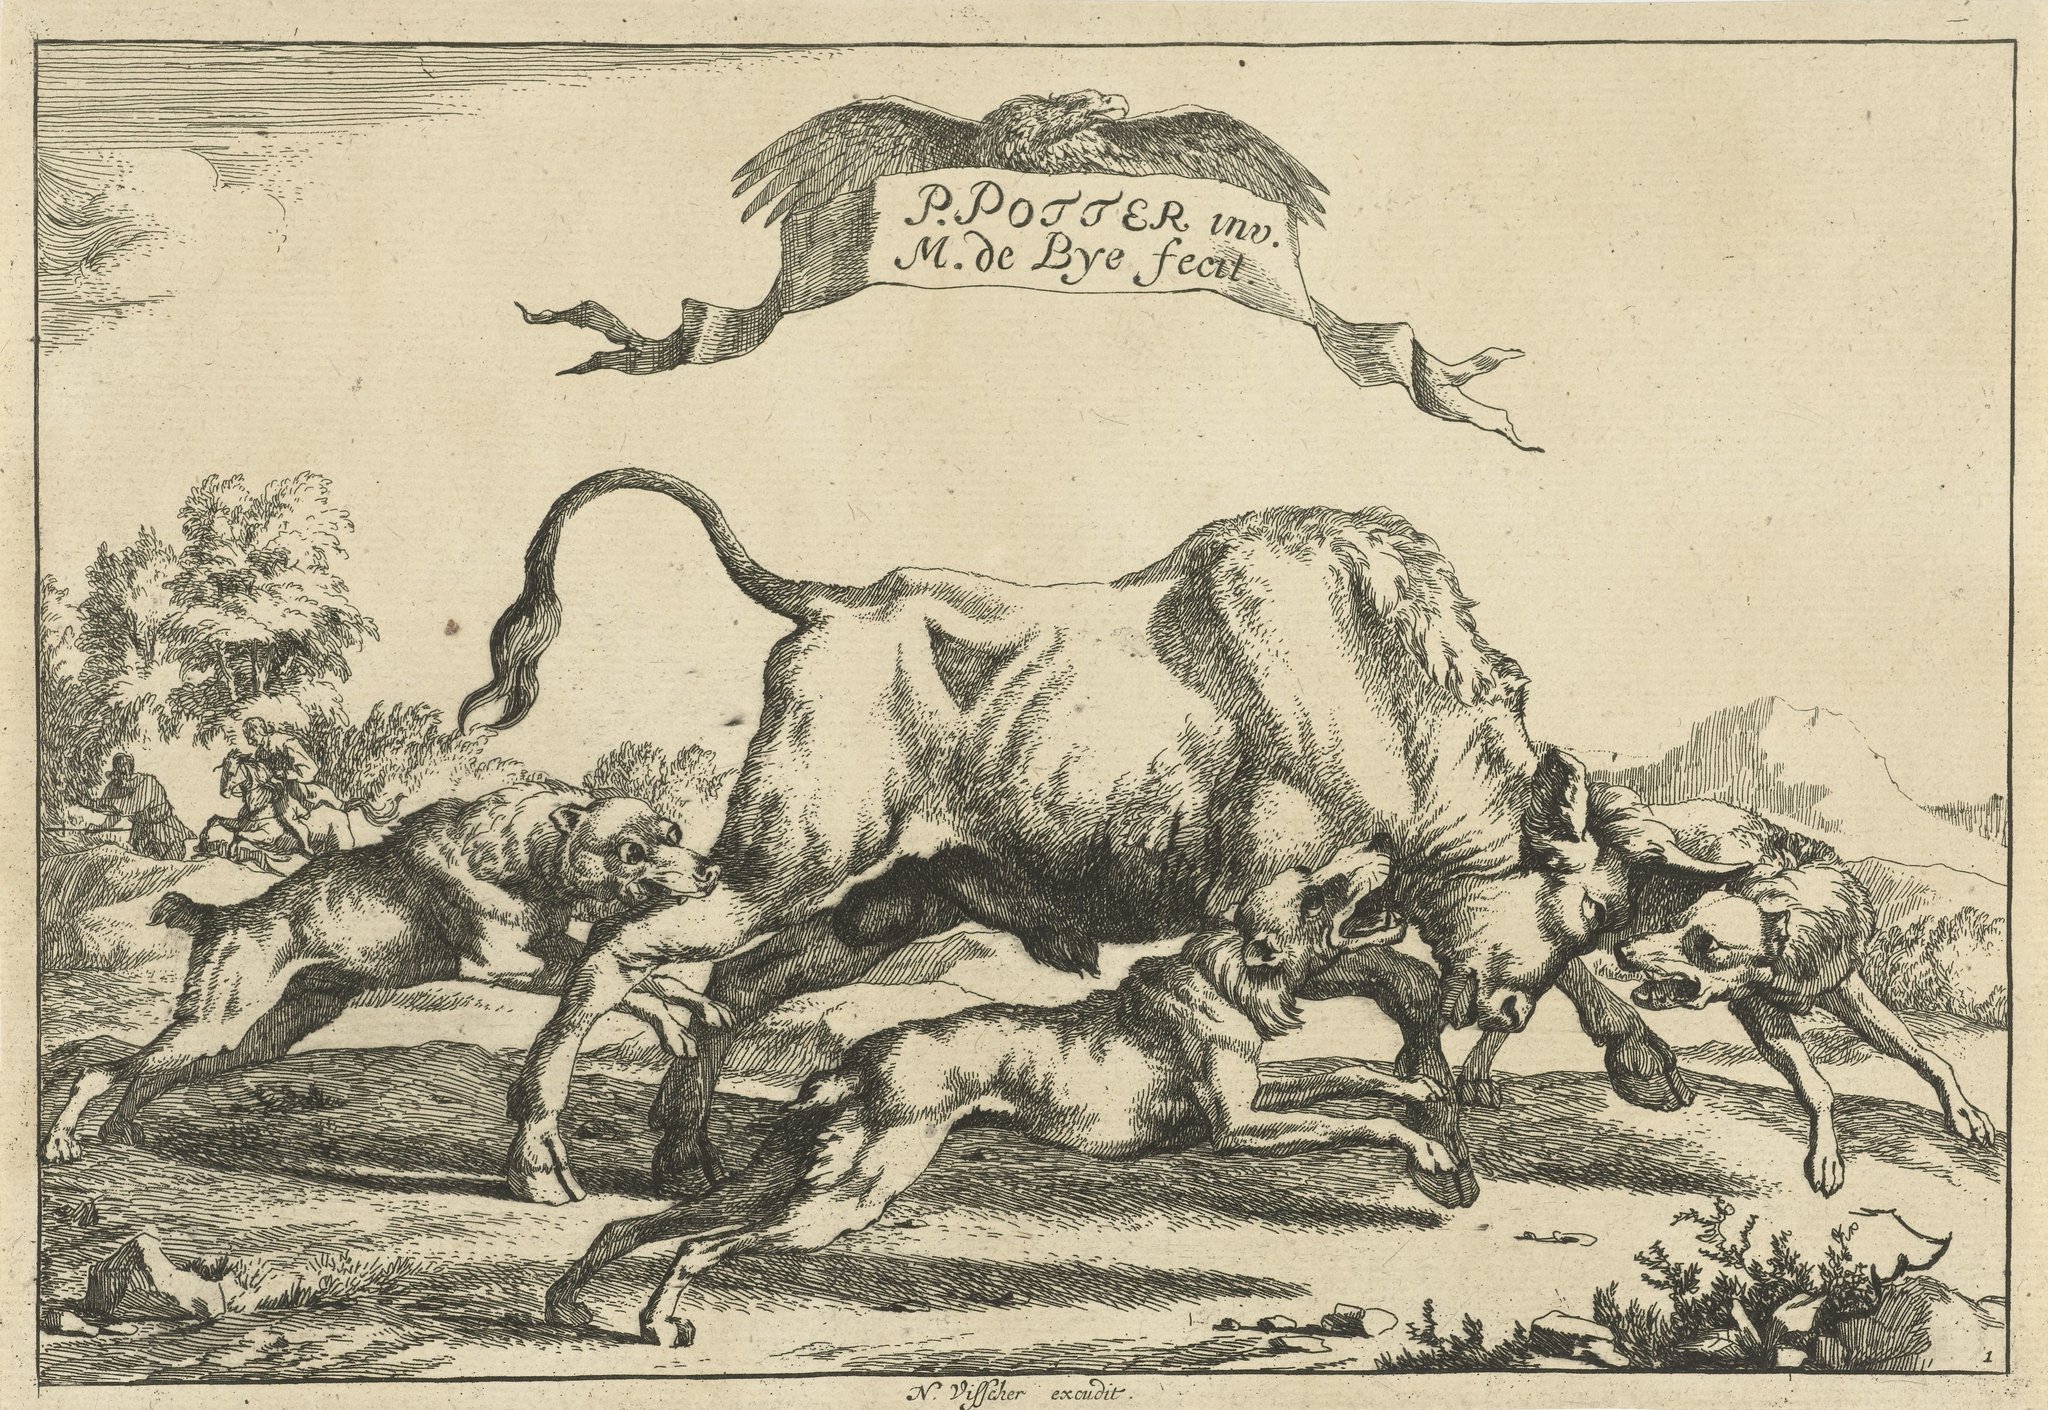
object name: print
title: Jachthonden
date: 1657-1677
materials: paper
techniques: etching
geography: amsterdam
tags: hunting, chase, hunting dogs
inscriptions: collector's mark: Lugt 2228